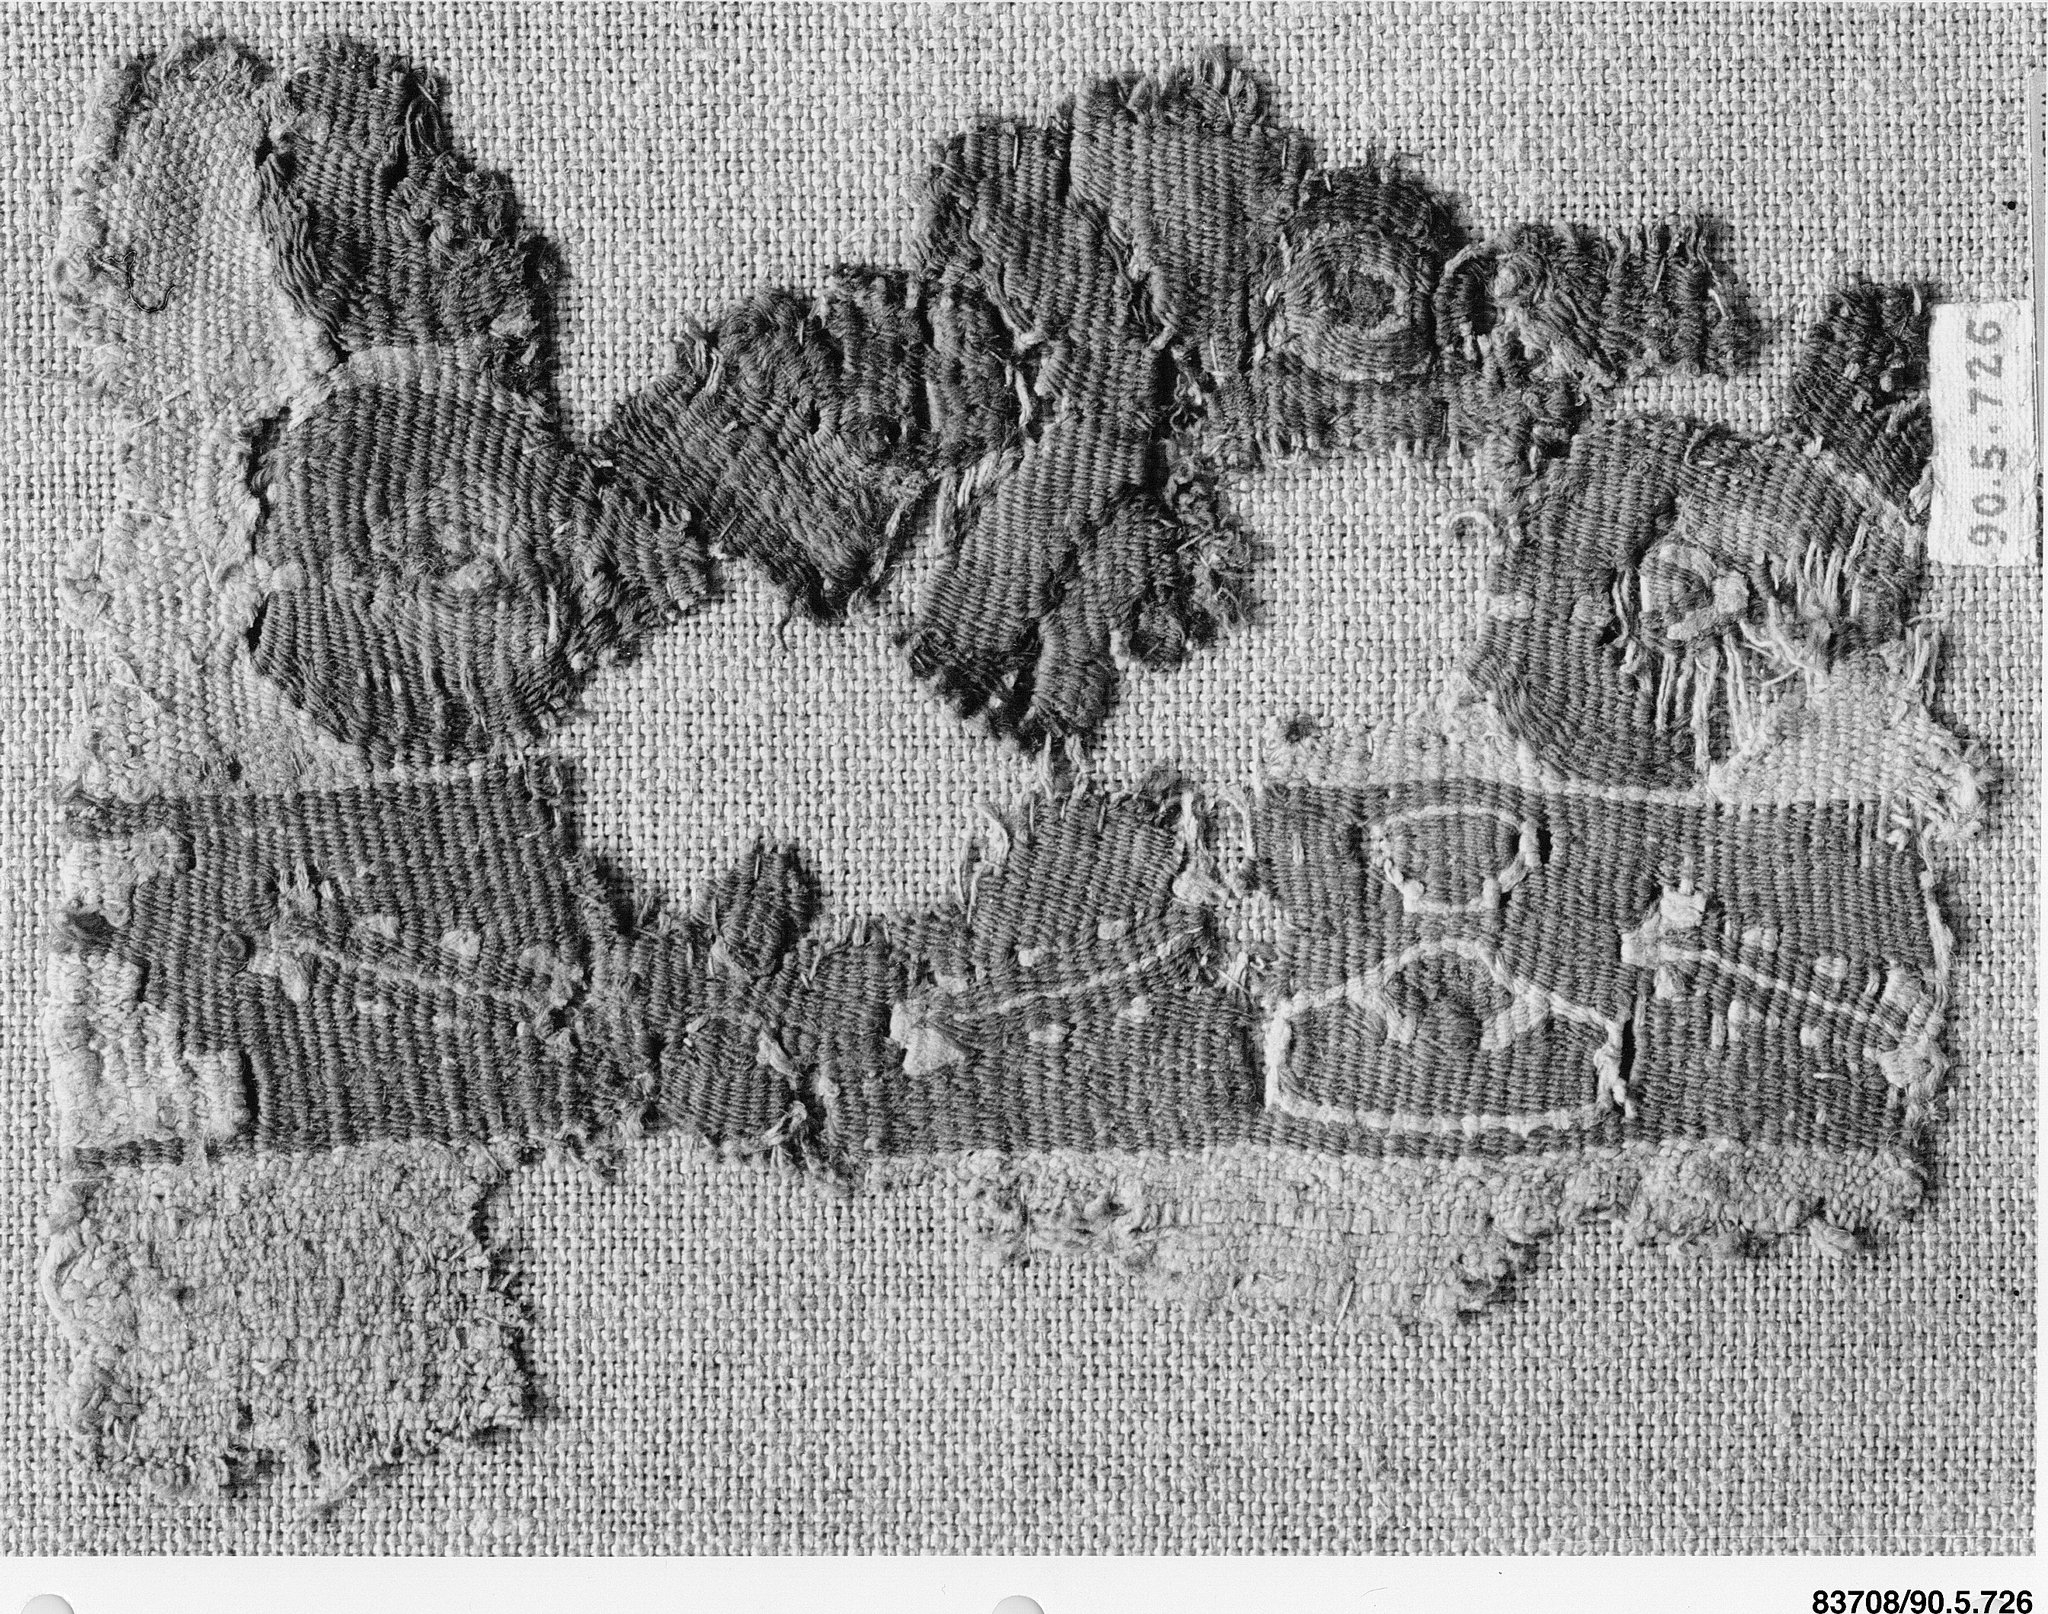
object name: textile fragment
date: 401-600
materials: linen, wool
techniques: weave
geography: egypt